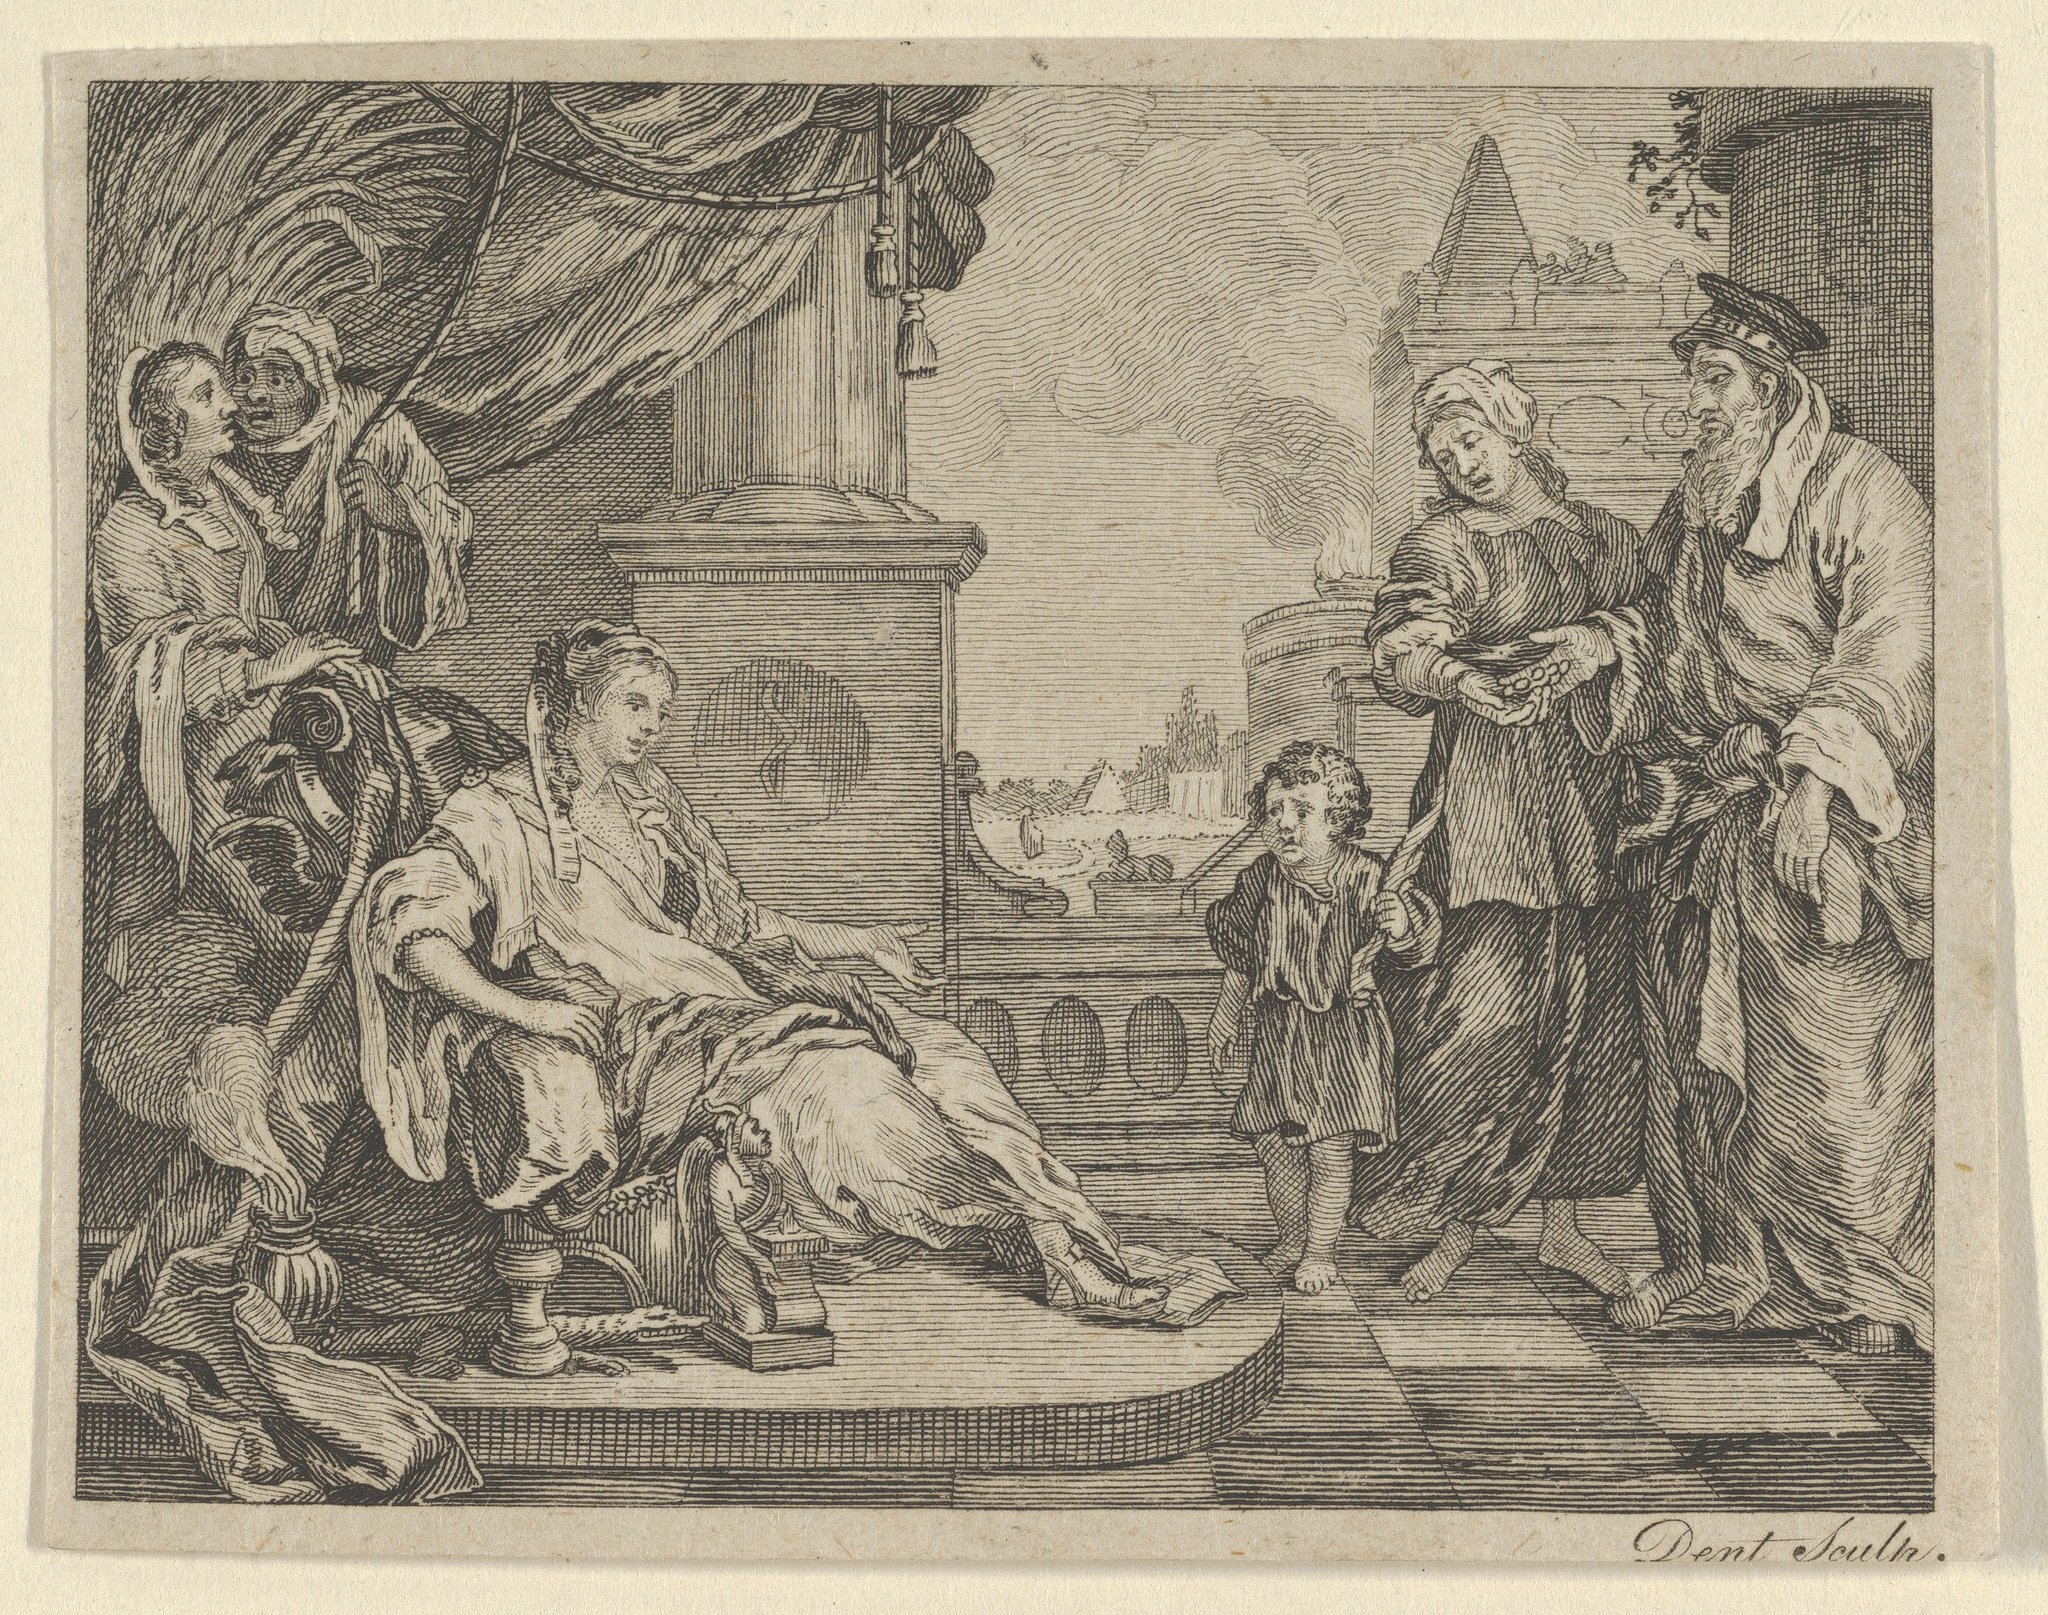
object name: print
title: Moses Brought to Pharoah's Daughter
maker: dent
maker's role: engraver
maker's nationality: british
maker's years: 1800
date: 1800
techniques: engraving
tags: boys,men,women,moses